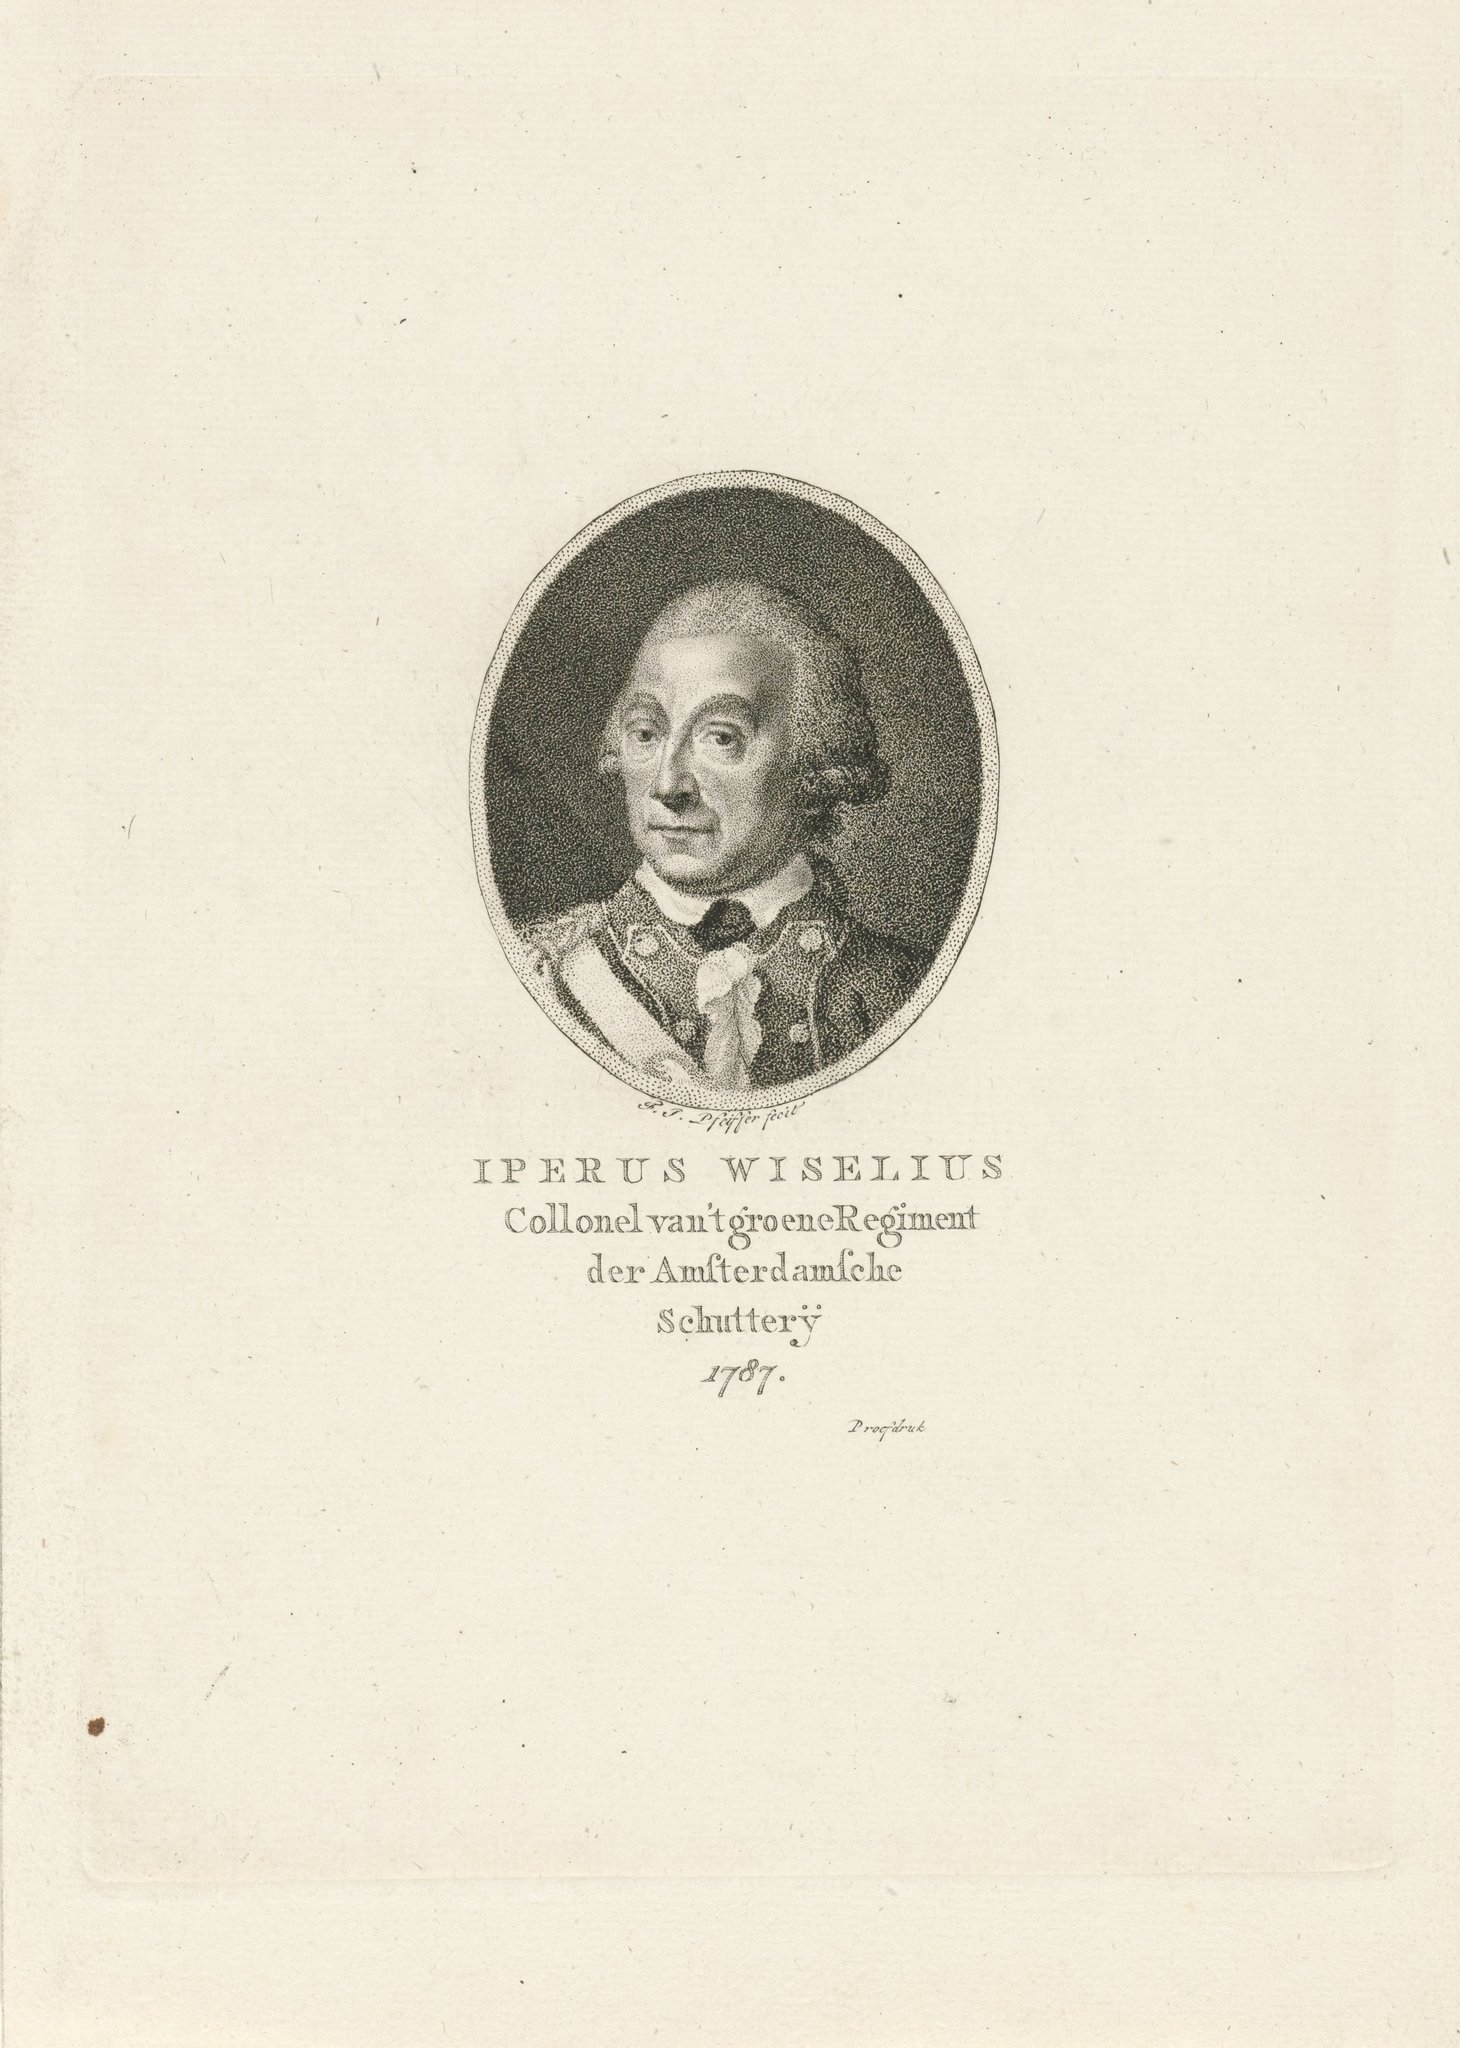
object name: print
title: Portret van Iperus Wiselius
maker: françois joseph pfeiffer (i)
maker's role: print maker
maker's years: 1741-1807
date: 1787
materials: paper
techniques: etching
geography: amsterdam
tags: kolonel, iperus wiselius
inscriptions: collector's mark: Lugt 2228